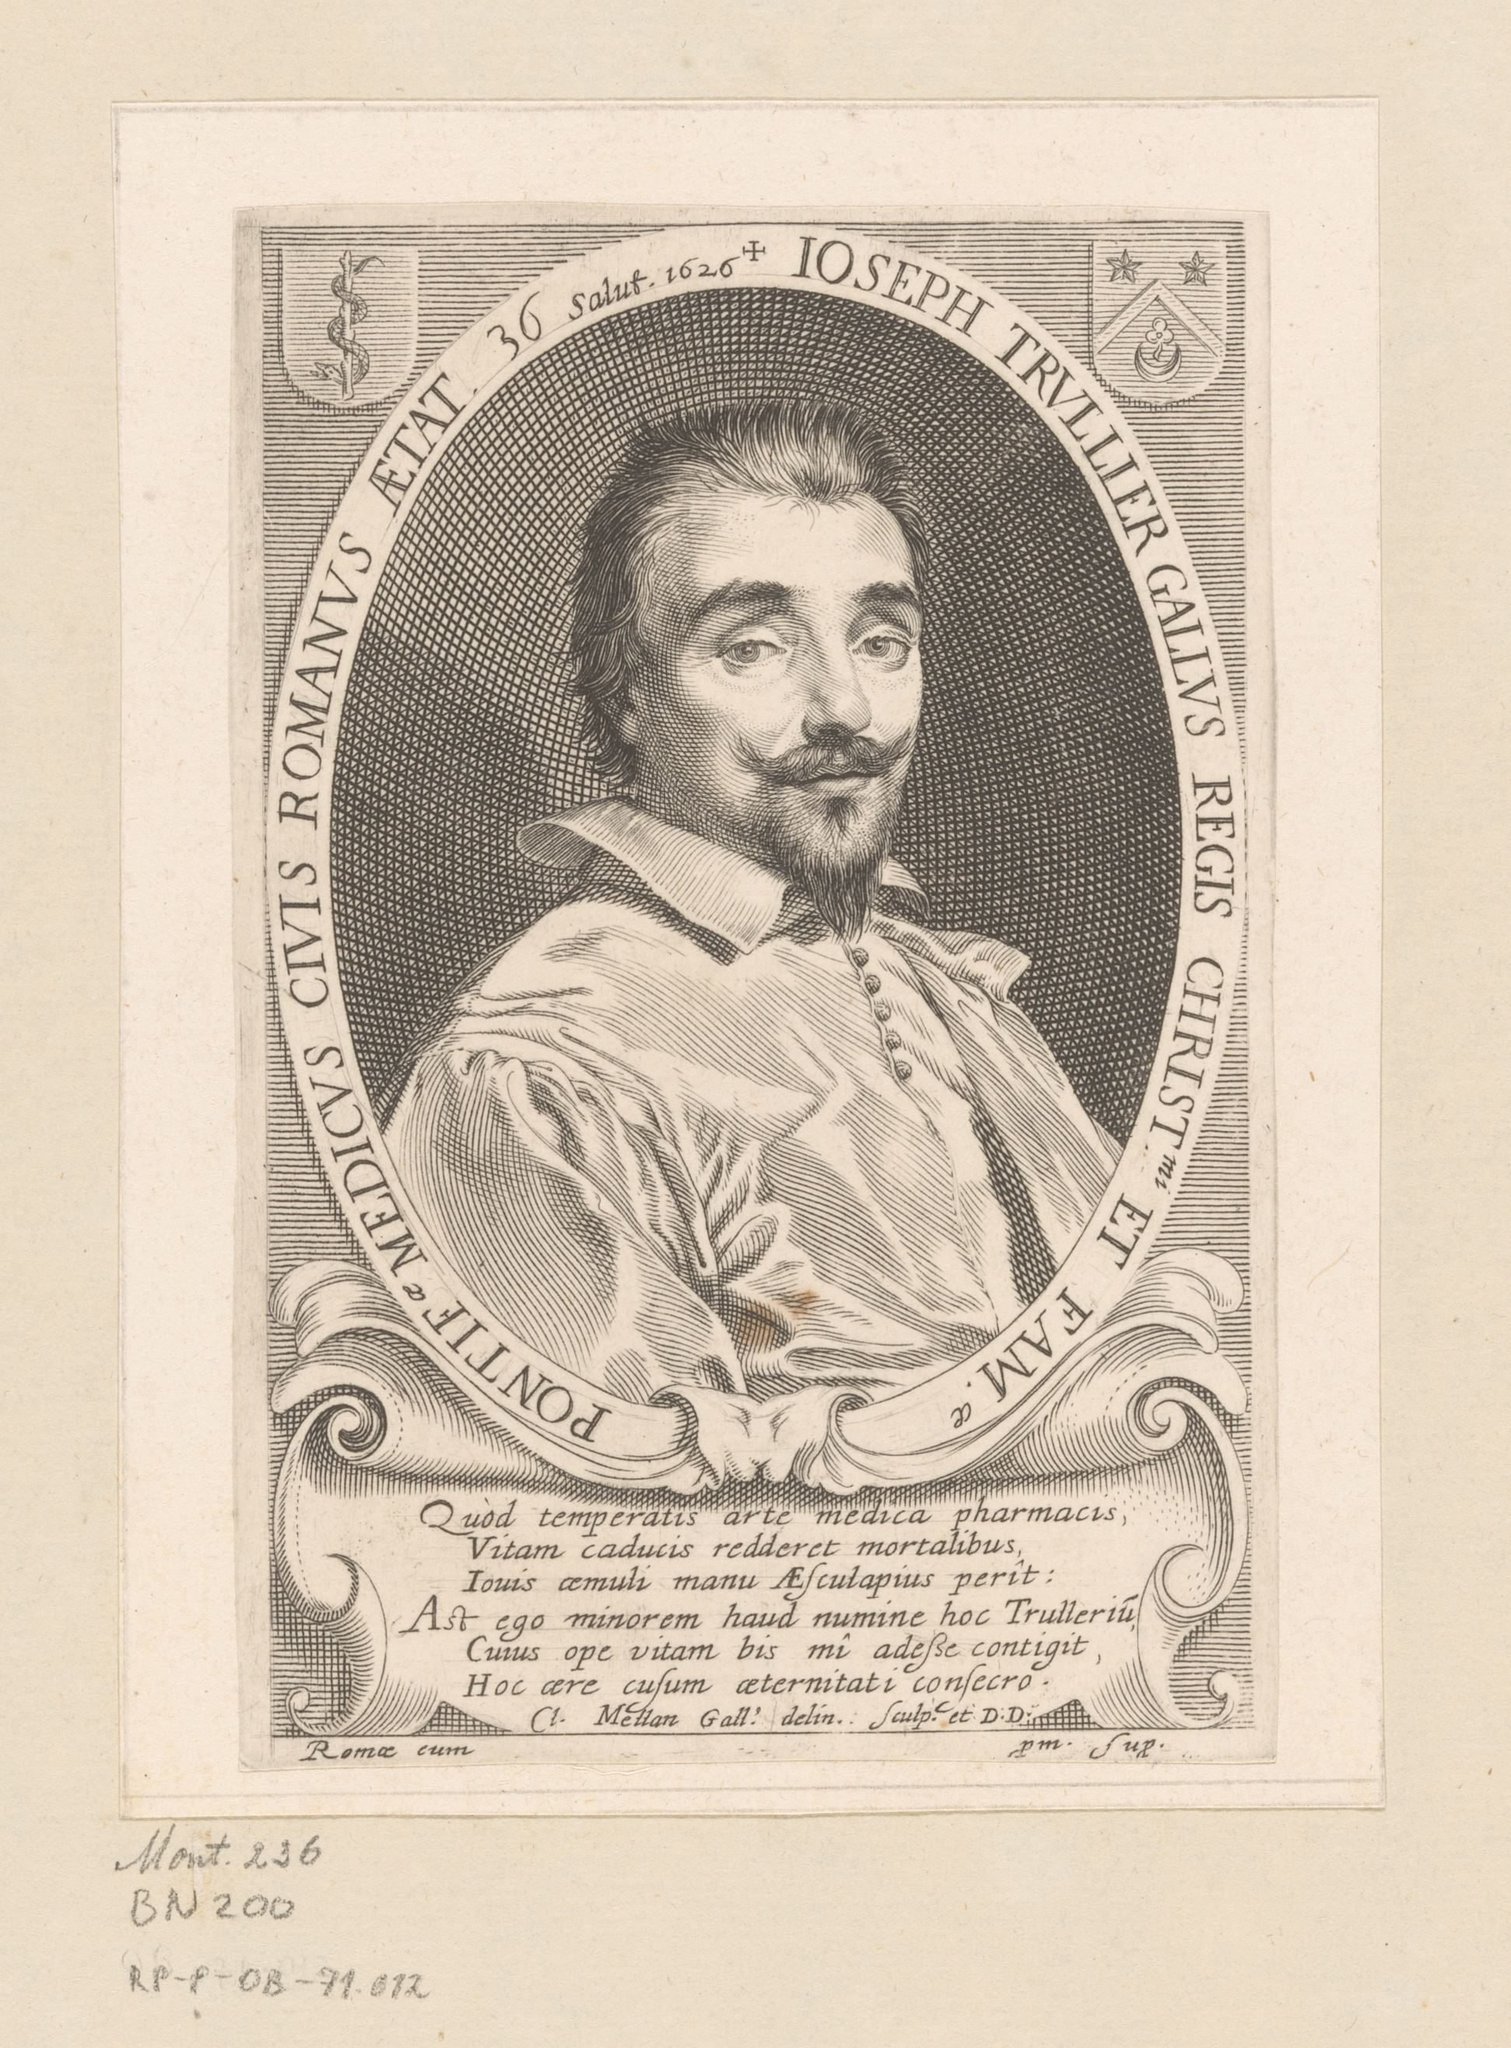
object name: print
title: Portret van Joseph Trullier op 36-jarige leeftijd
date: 1626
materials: paper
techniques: engraving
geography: italy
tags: joseph trullier, historical persons, armorial bearing, heraldry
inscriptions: collector's mark: Lugt 240